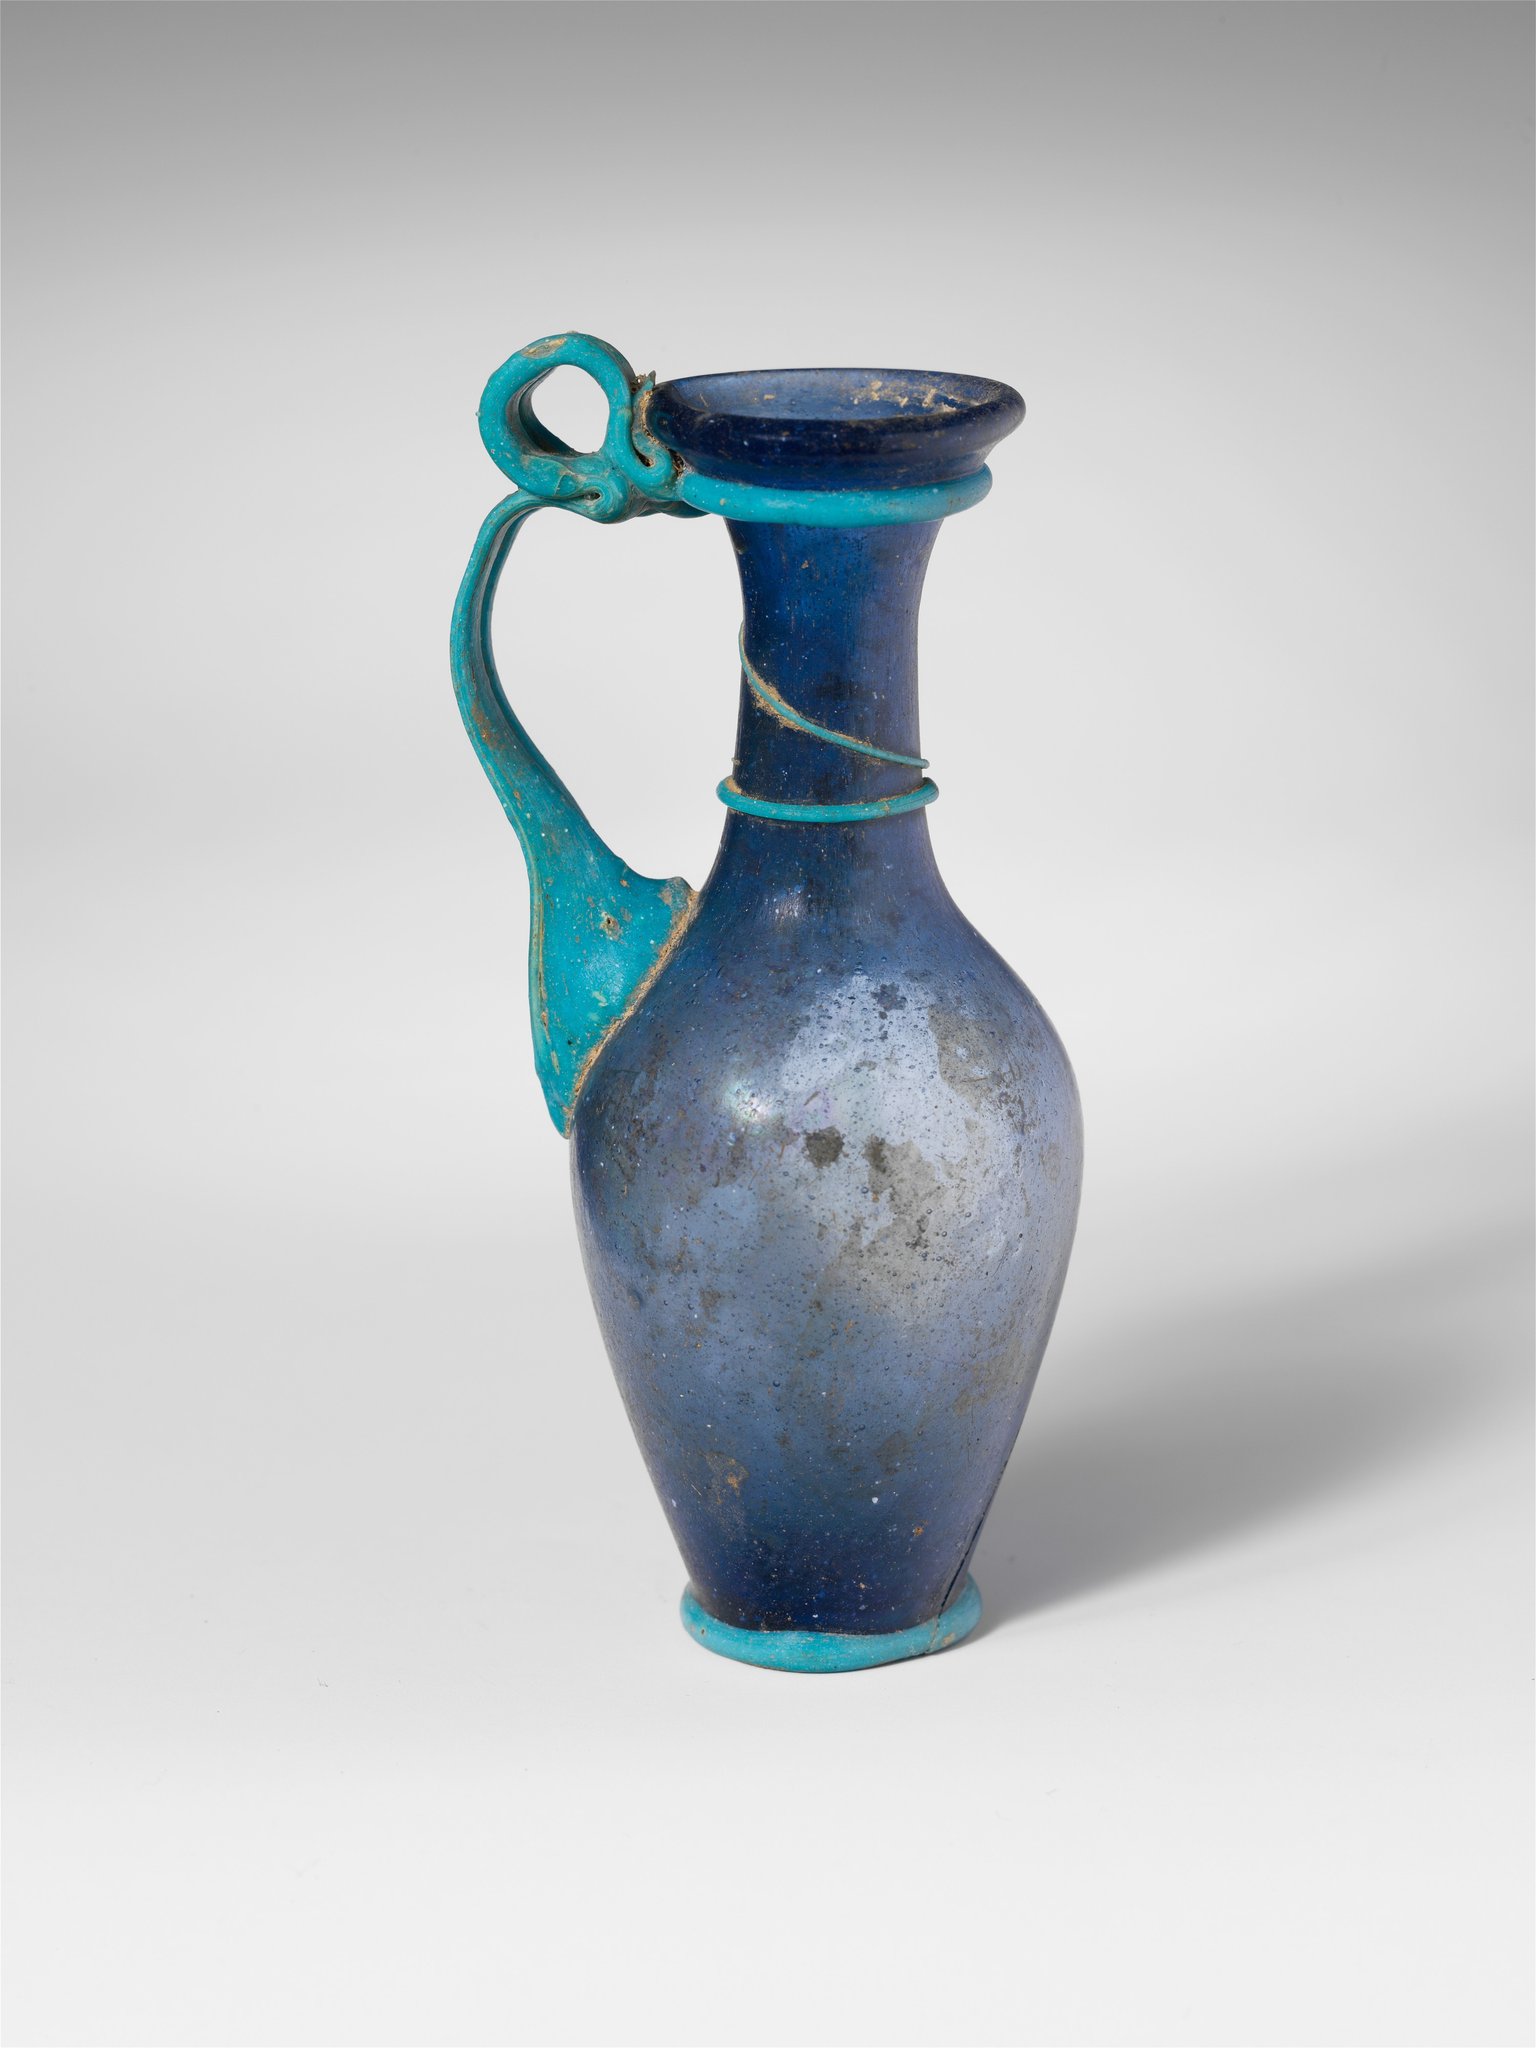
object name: jug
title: Glass jug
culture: roman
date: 301-400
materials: glass